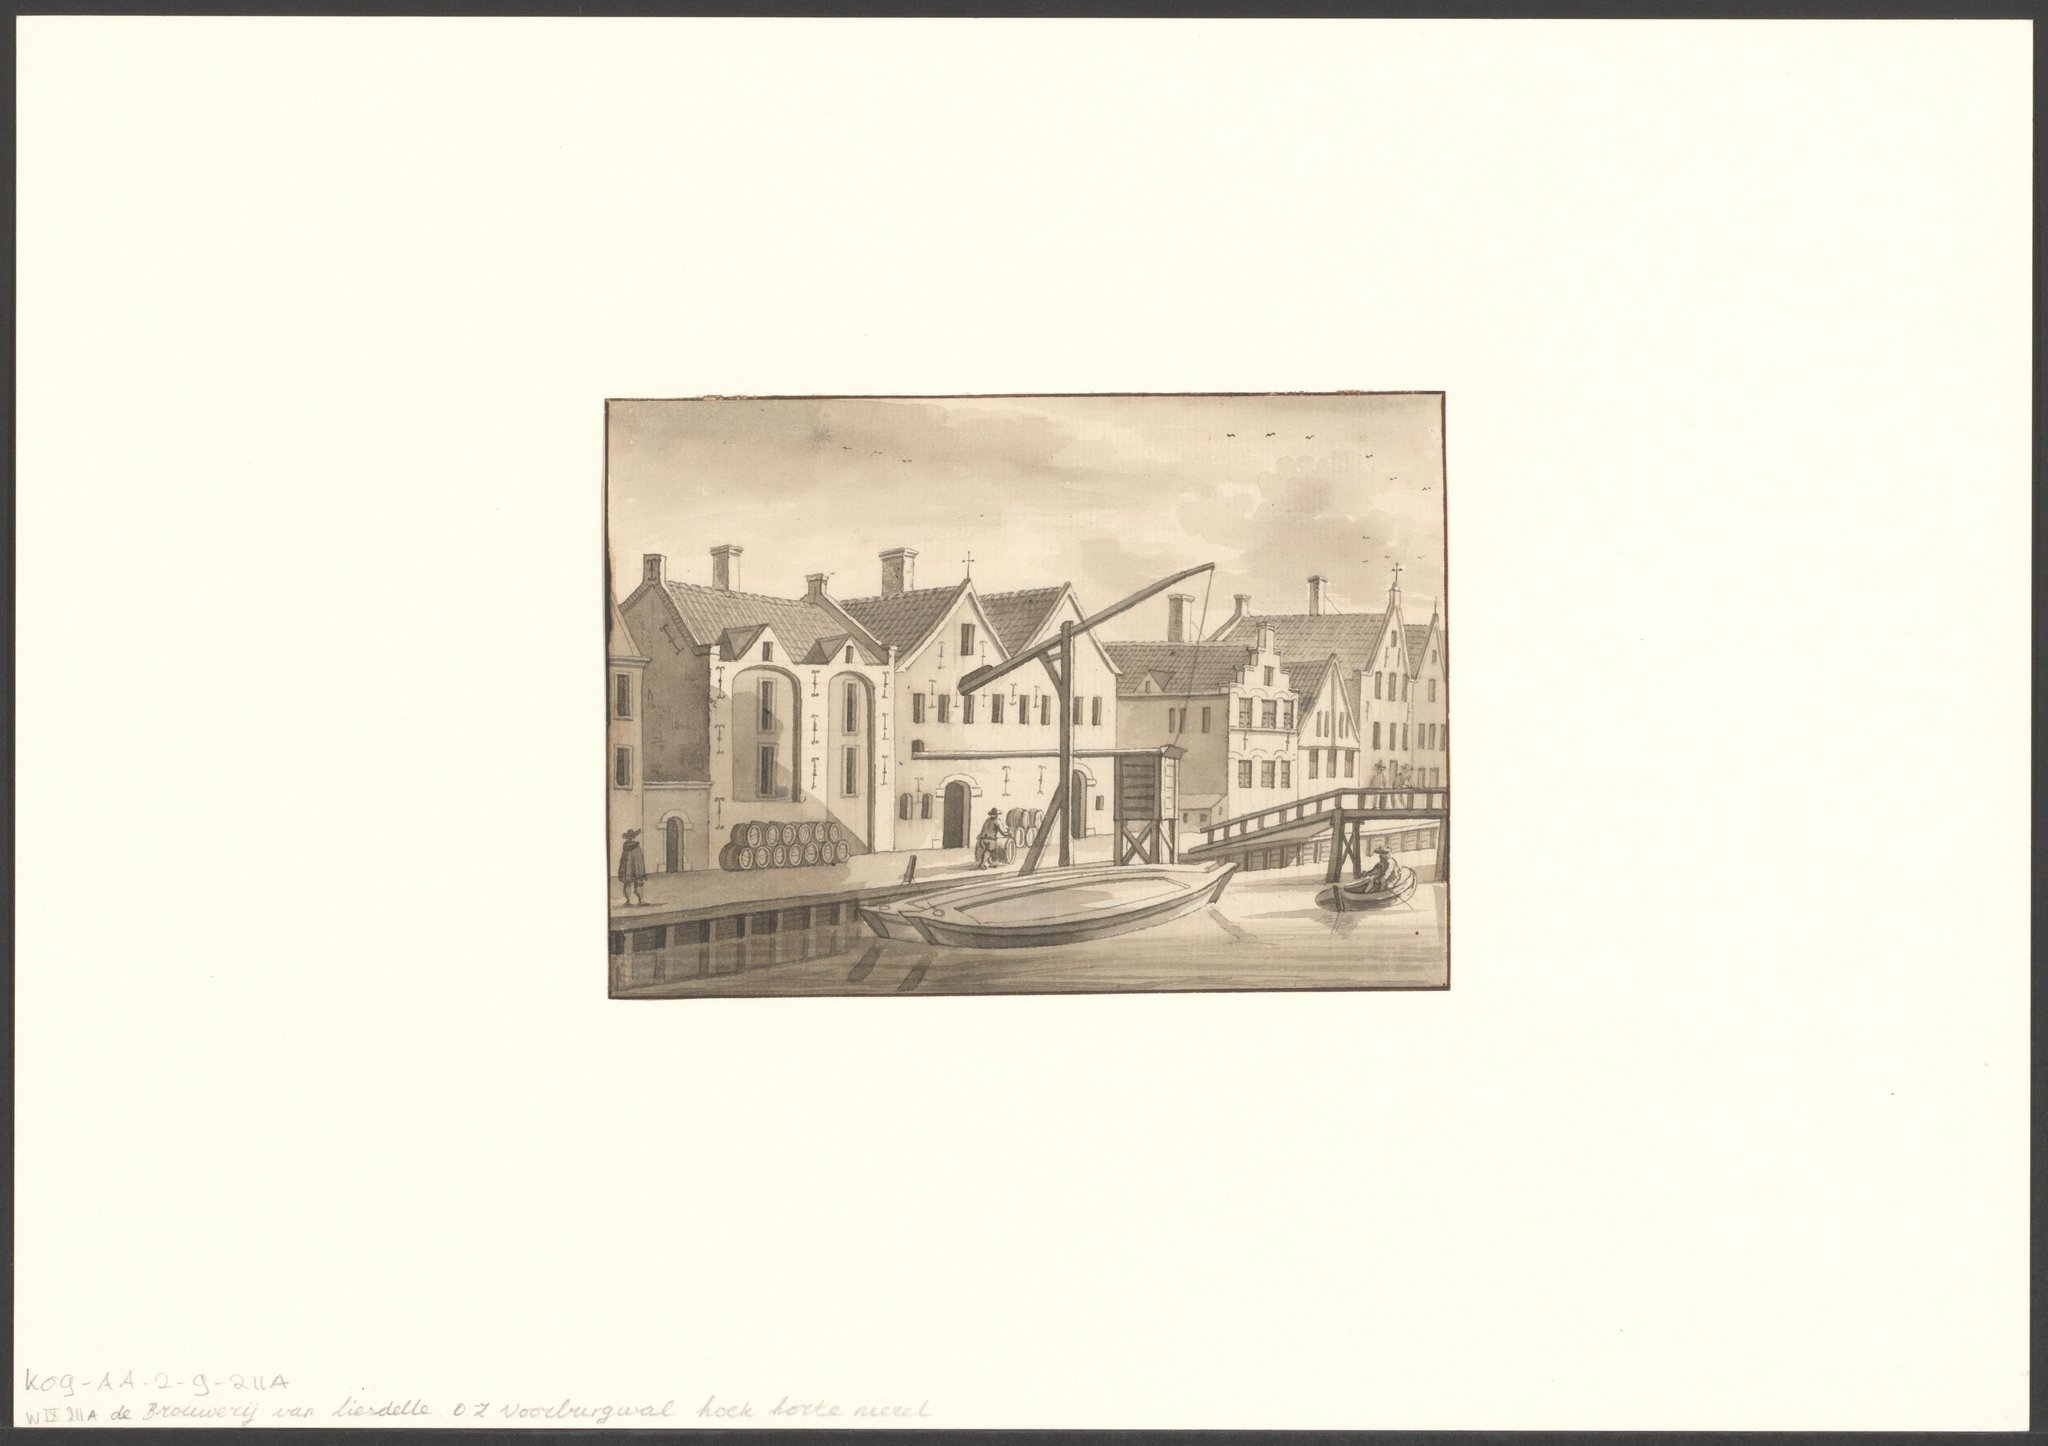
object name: drawing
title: Gezicht op de brouwerij van Liesdelle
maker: antonina houbraken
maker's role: draughtsman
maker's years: 1696-1736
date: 1706-1736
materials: ink, paper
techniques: brush, pen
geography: amsterdam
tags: city-view in general; 'veduta', canal, bridge in city across river, canal, etc., boat propelled by man or animal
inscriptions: collector's mark: Lugt 800a, inscription: ‘De Brouwerij van Liesdelle’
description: Tekening binnen de Atlas Van Eck ingedeeld op wijknummer 9.